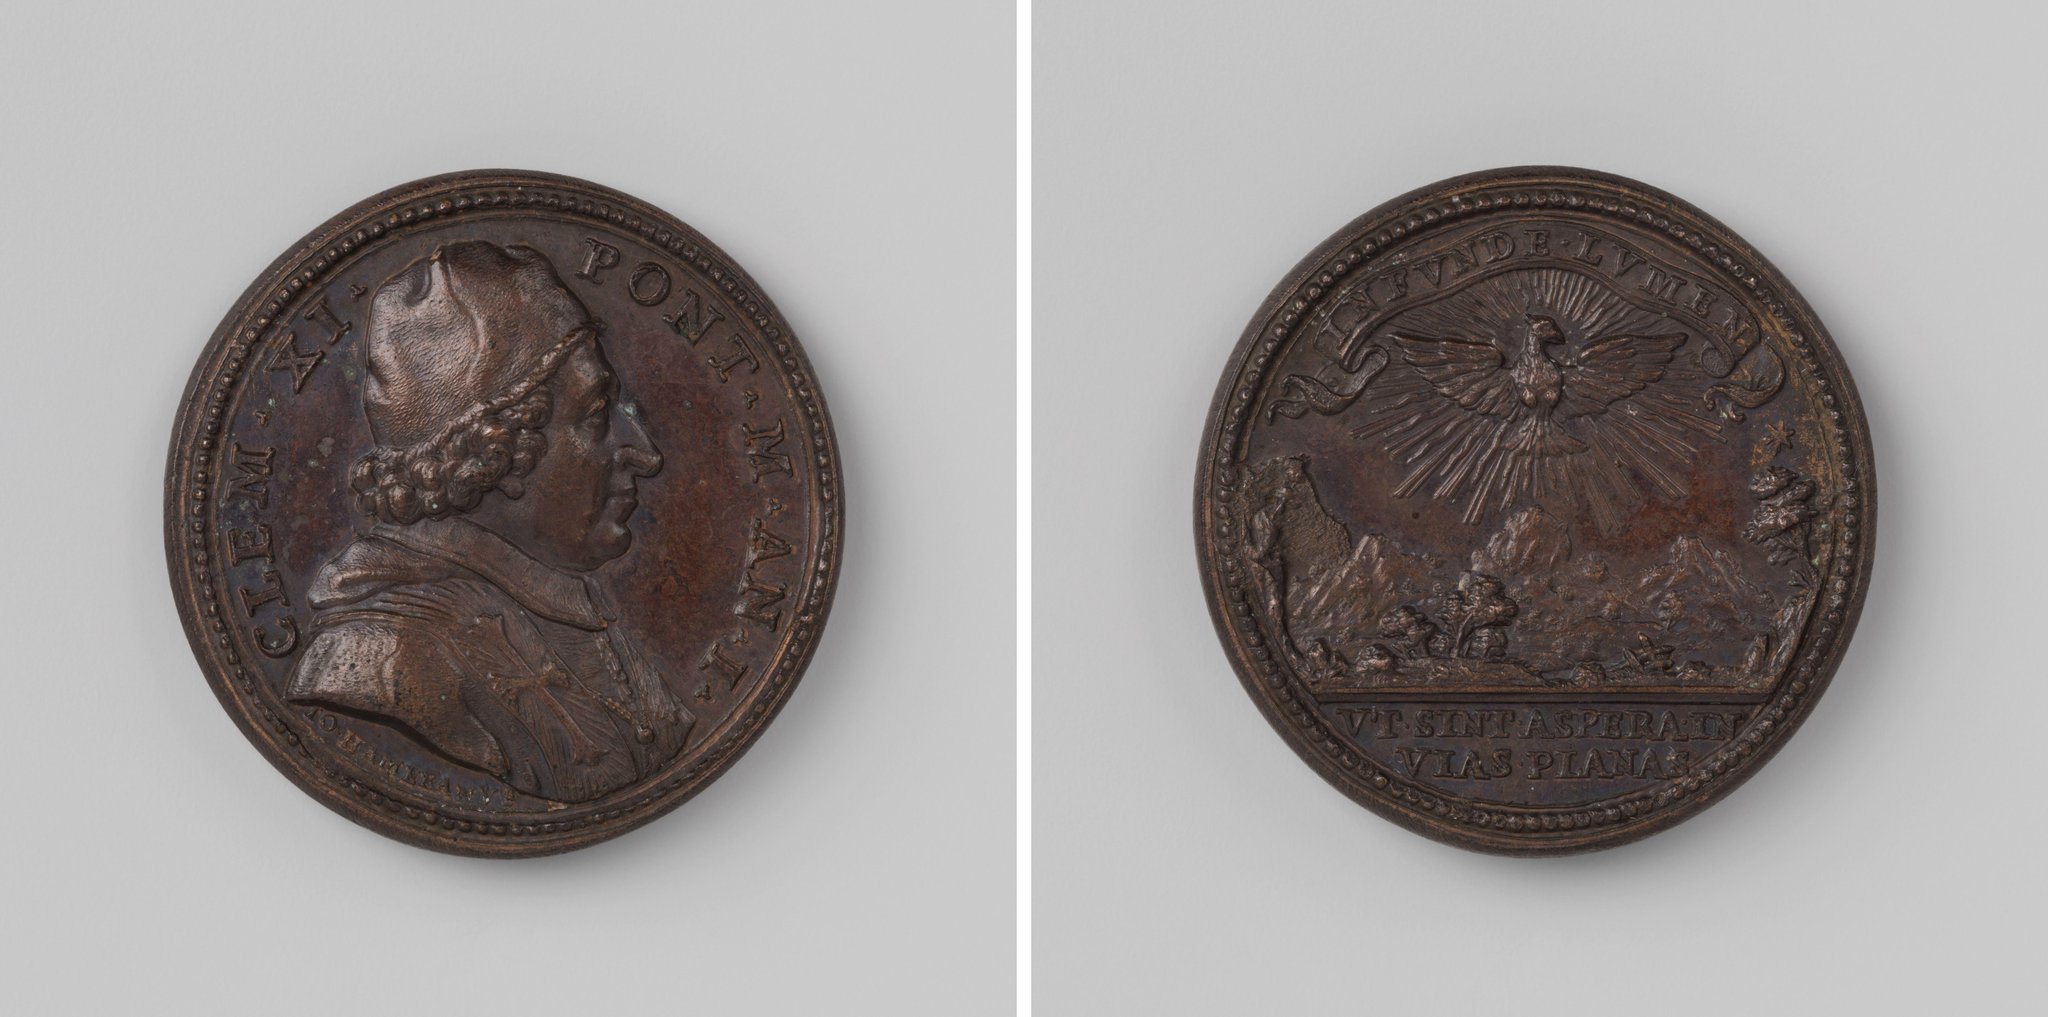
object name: history medal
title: Inspanningen van Clemens XI om de vrede te bewaren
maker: giovanni hamerani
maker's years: 1649-1705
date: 1701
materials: bronze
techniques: striking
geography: rome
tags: clergyman, clemens xi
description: Bronzen penning. Voorzijde: borststuk man binnen omschrift. Keerzijde: duif met stralenkrans vliegend over bergachtig landschap onder wimpel met opschrift, boven opschrift.